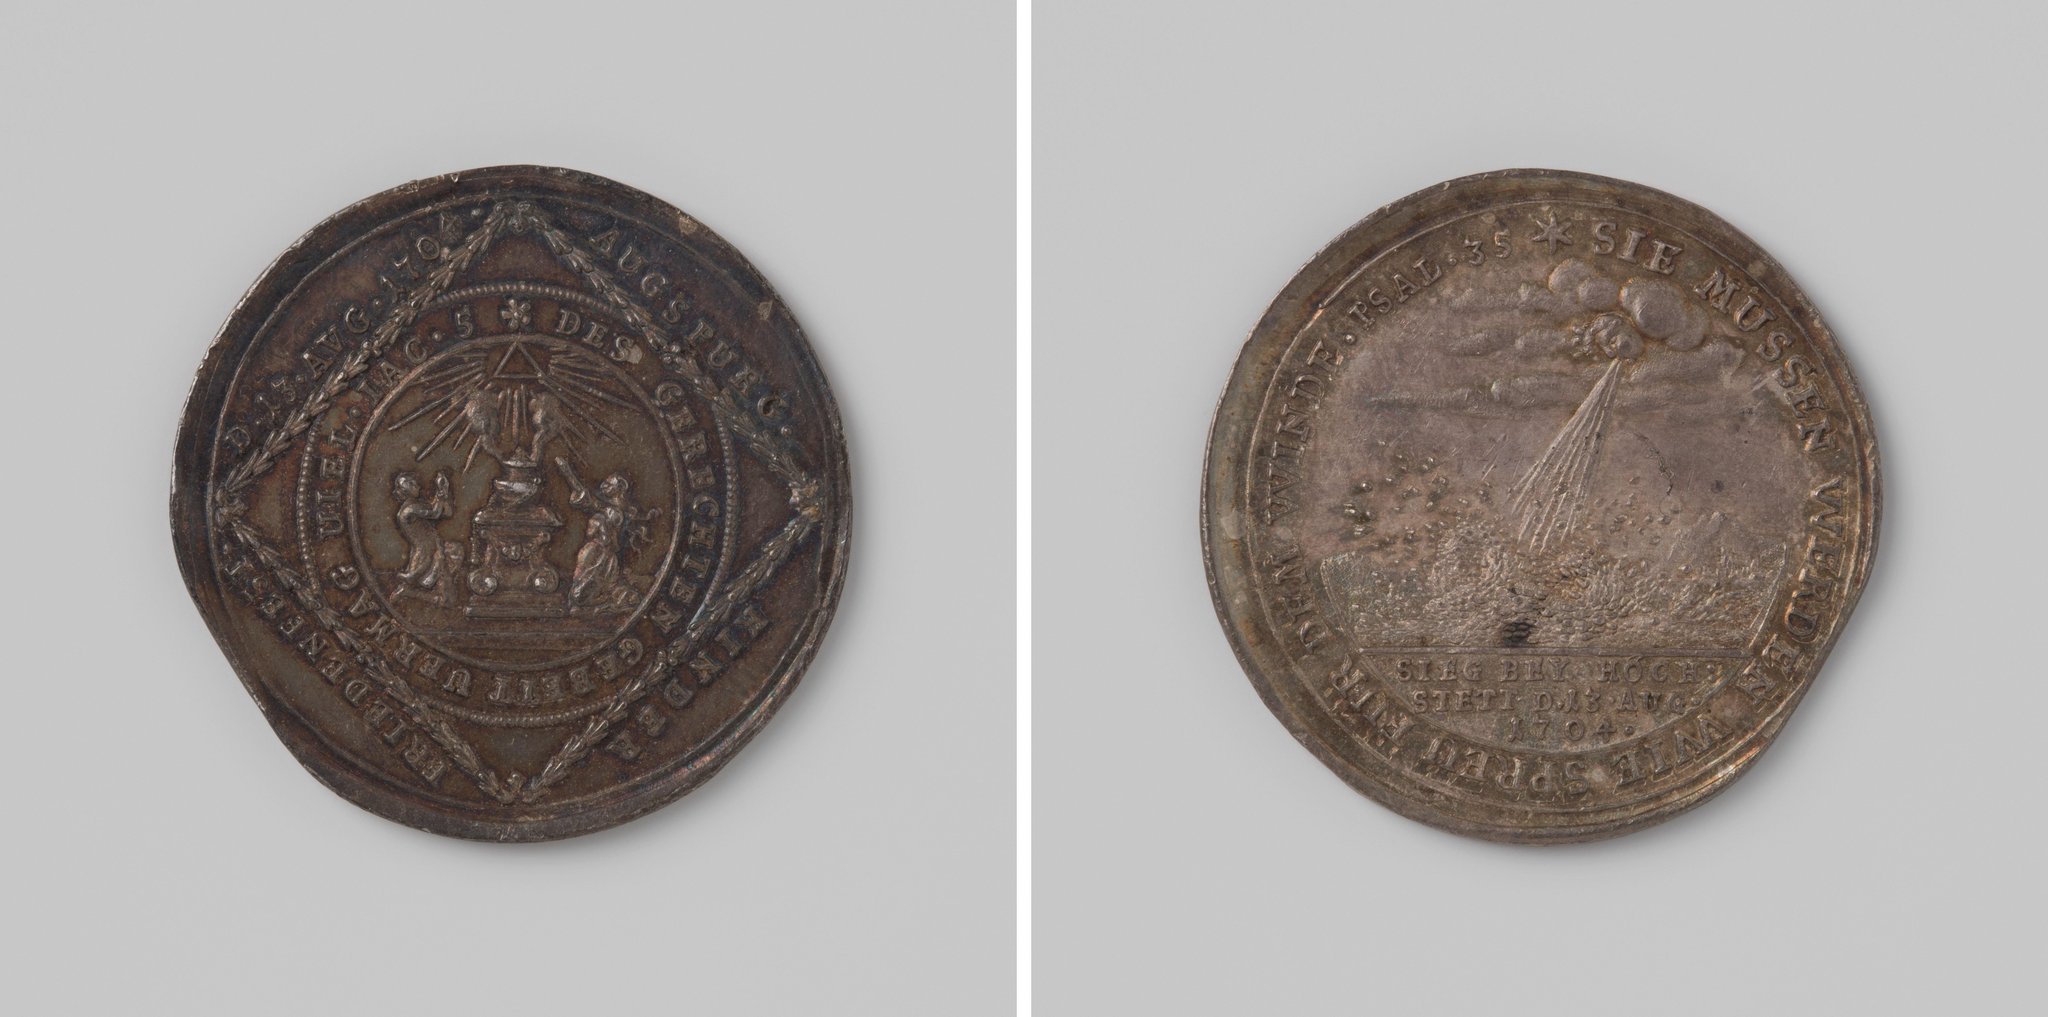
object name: jeton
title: Vredesfeest van de kinderen te Augsburg en herdenking van de slag bij Blenheim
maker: Anonymous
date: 1704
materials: silver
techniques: striking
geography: germany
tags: augsburg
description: Zilveren penning. Voorzijde: jongen en meisje knielend in gebed aan weerszijden van altaar beschenen door stralende driehoek binnen rand met omschrift, daaromheen rechthoek van laurierbladeren en omschrift. Keerzijde: wind blaast wolken stof weg boven opschrift, binnen omschrif